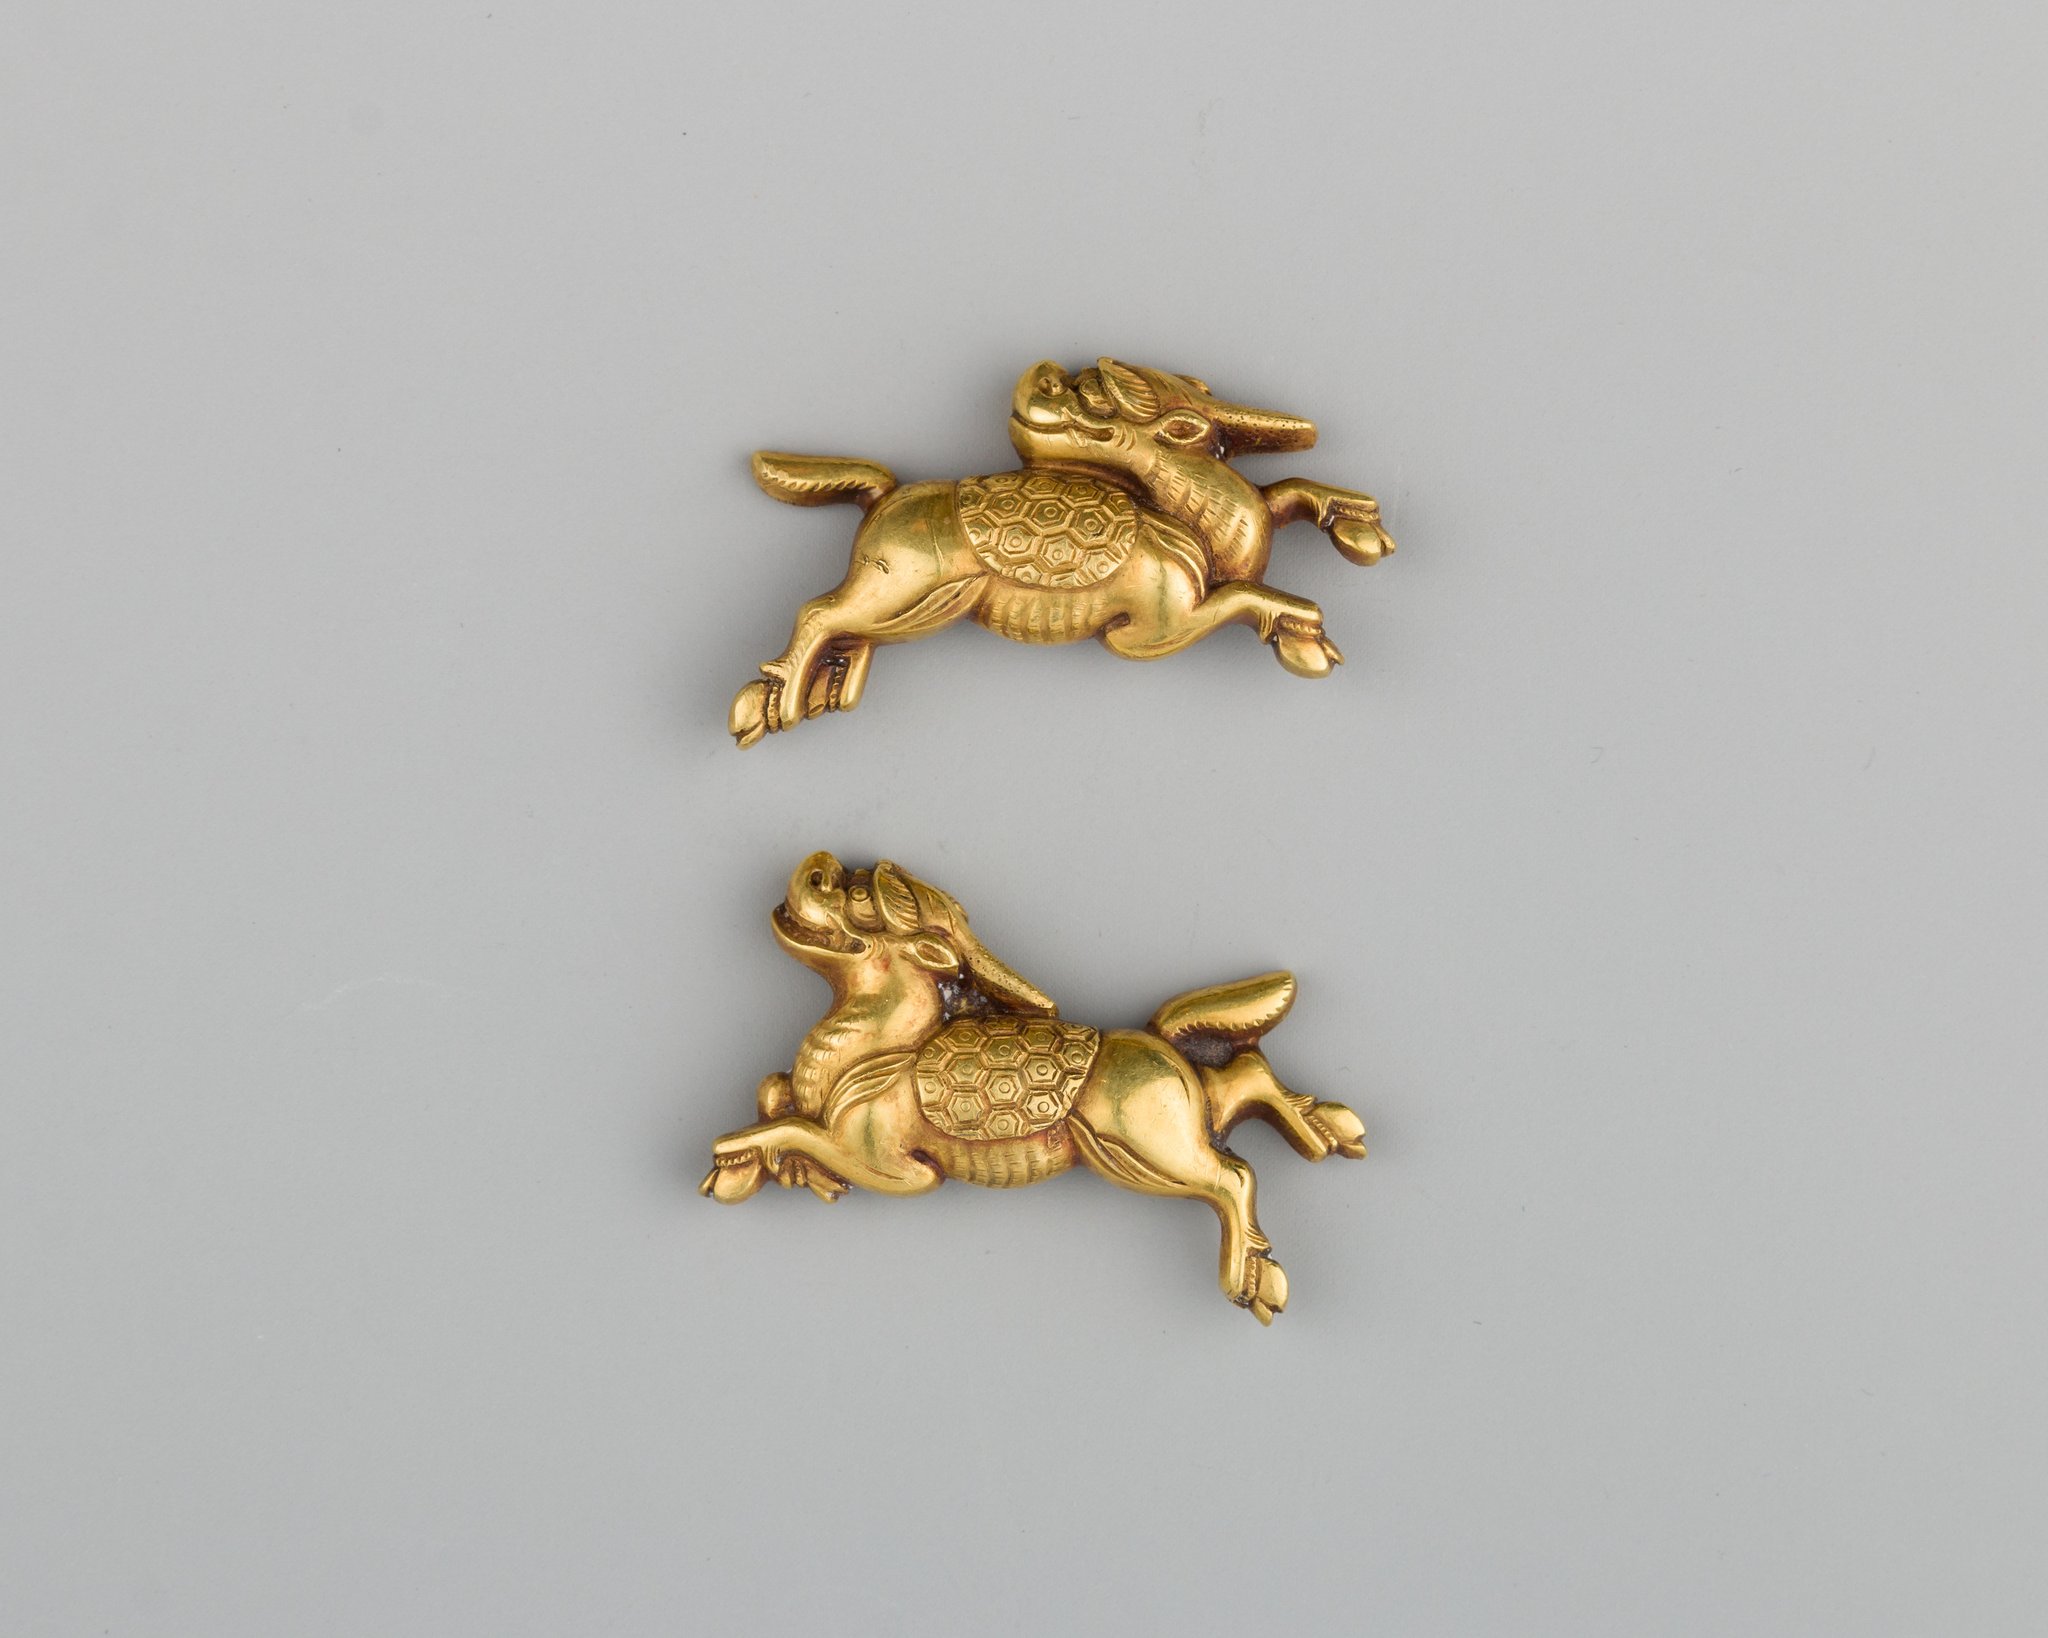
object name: pair of sword grip ornament menuki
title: Pair of Sword-Grip Ornaments (Menuki)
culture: japanese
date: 1701-1800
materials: gold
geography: japan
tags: animals